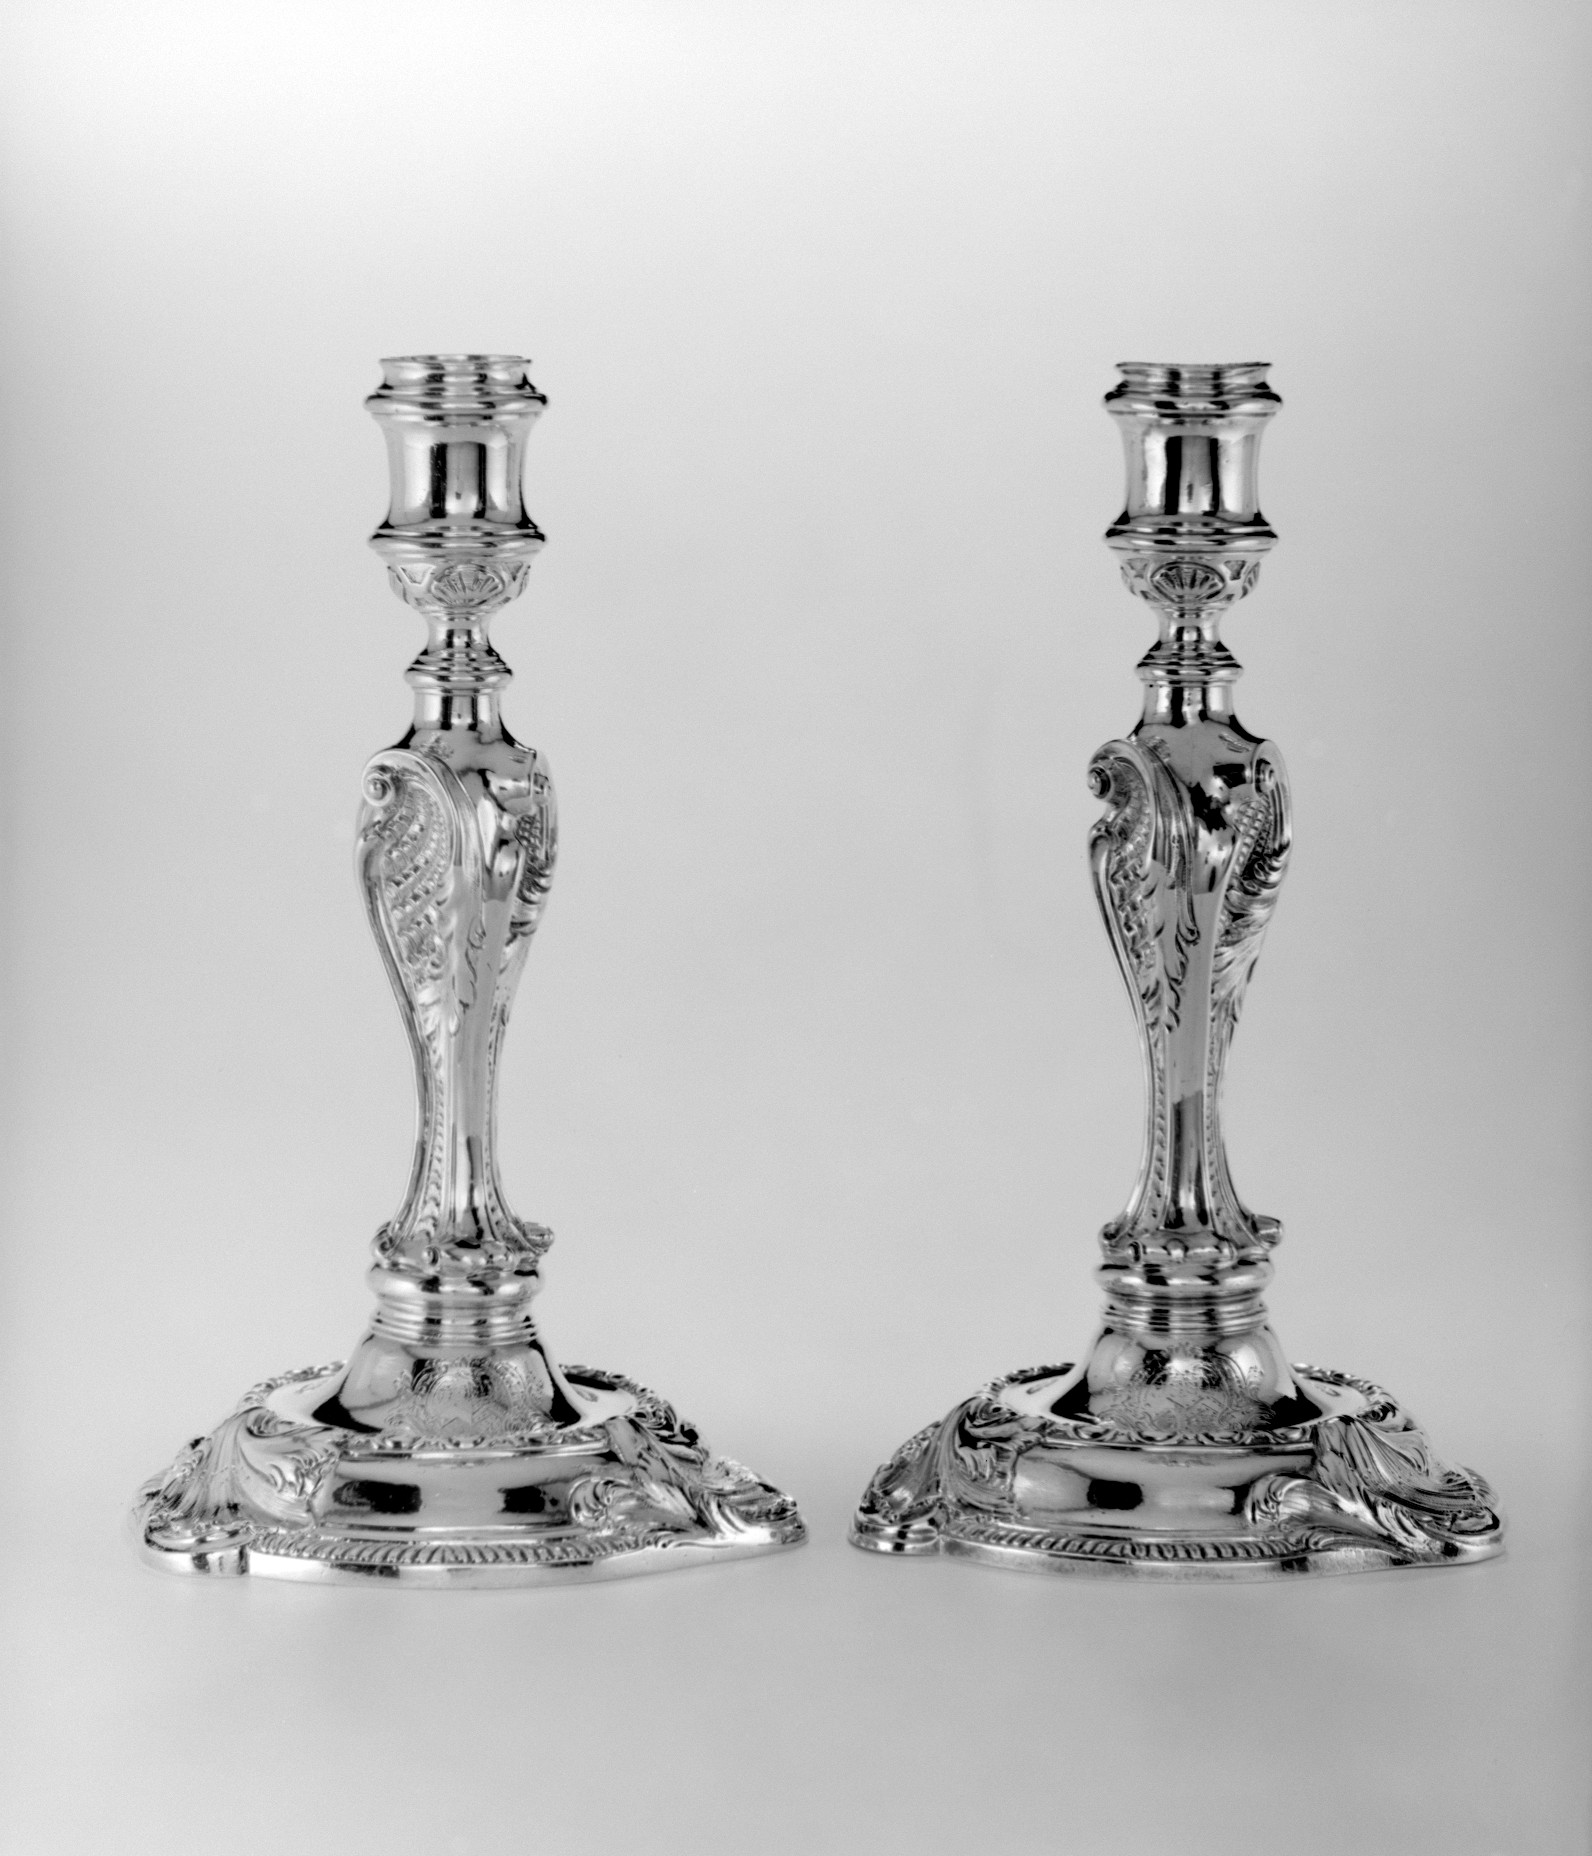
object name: candlestick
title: Pair of candlesticks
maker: thomas gilpin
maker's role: maker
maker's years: 1730-1773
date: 1745-1746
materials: silver